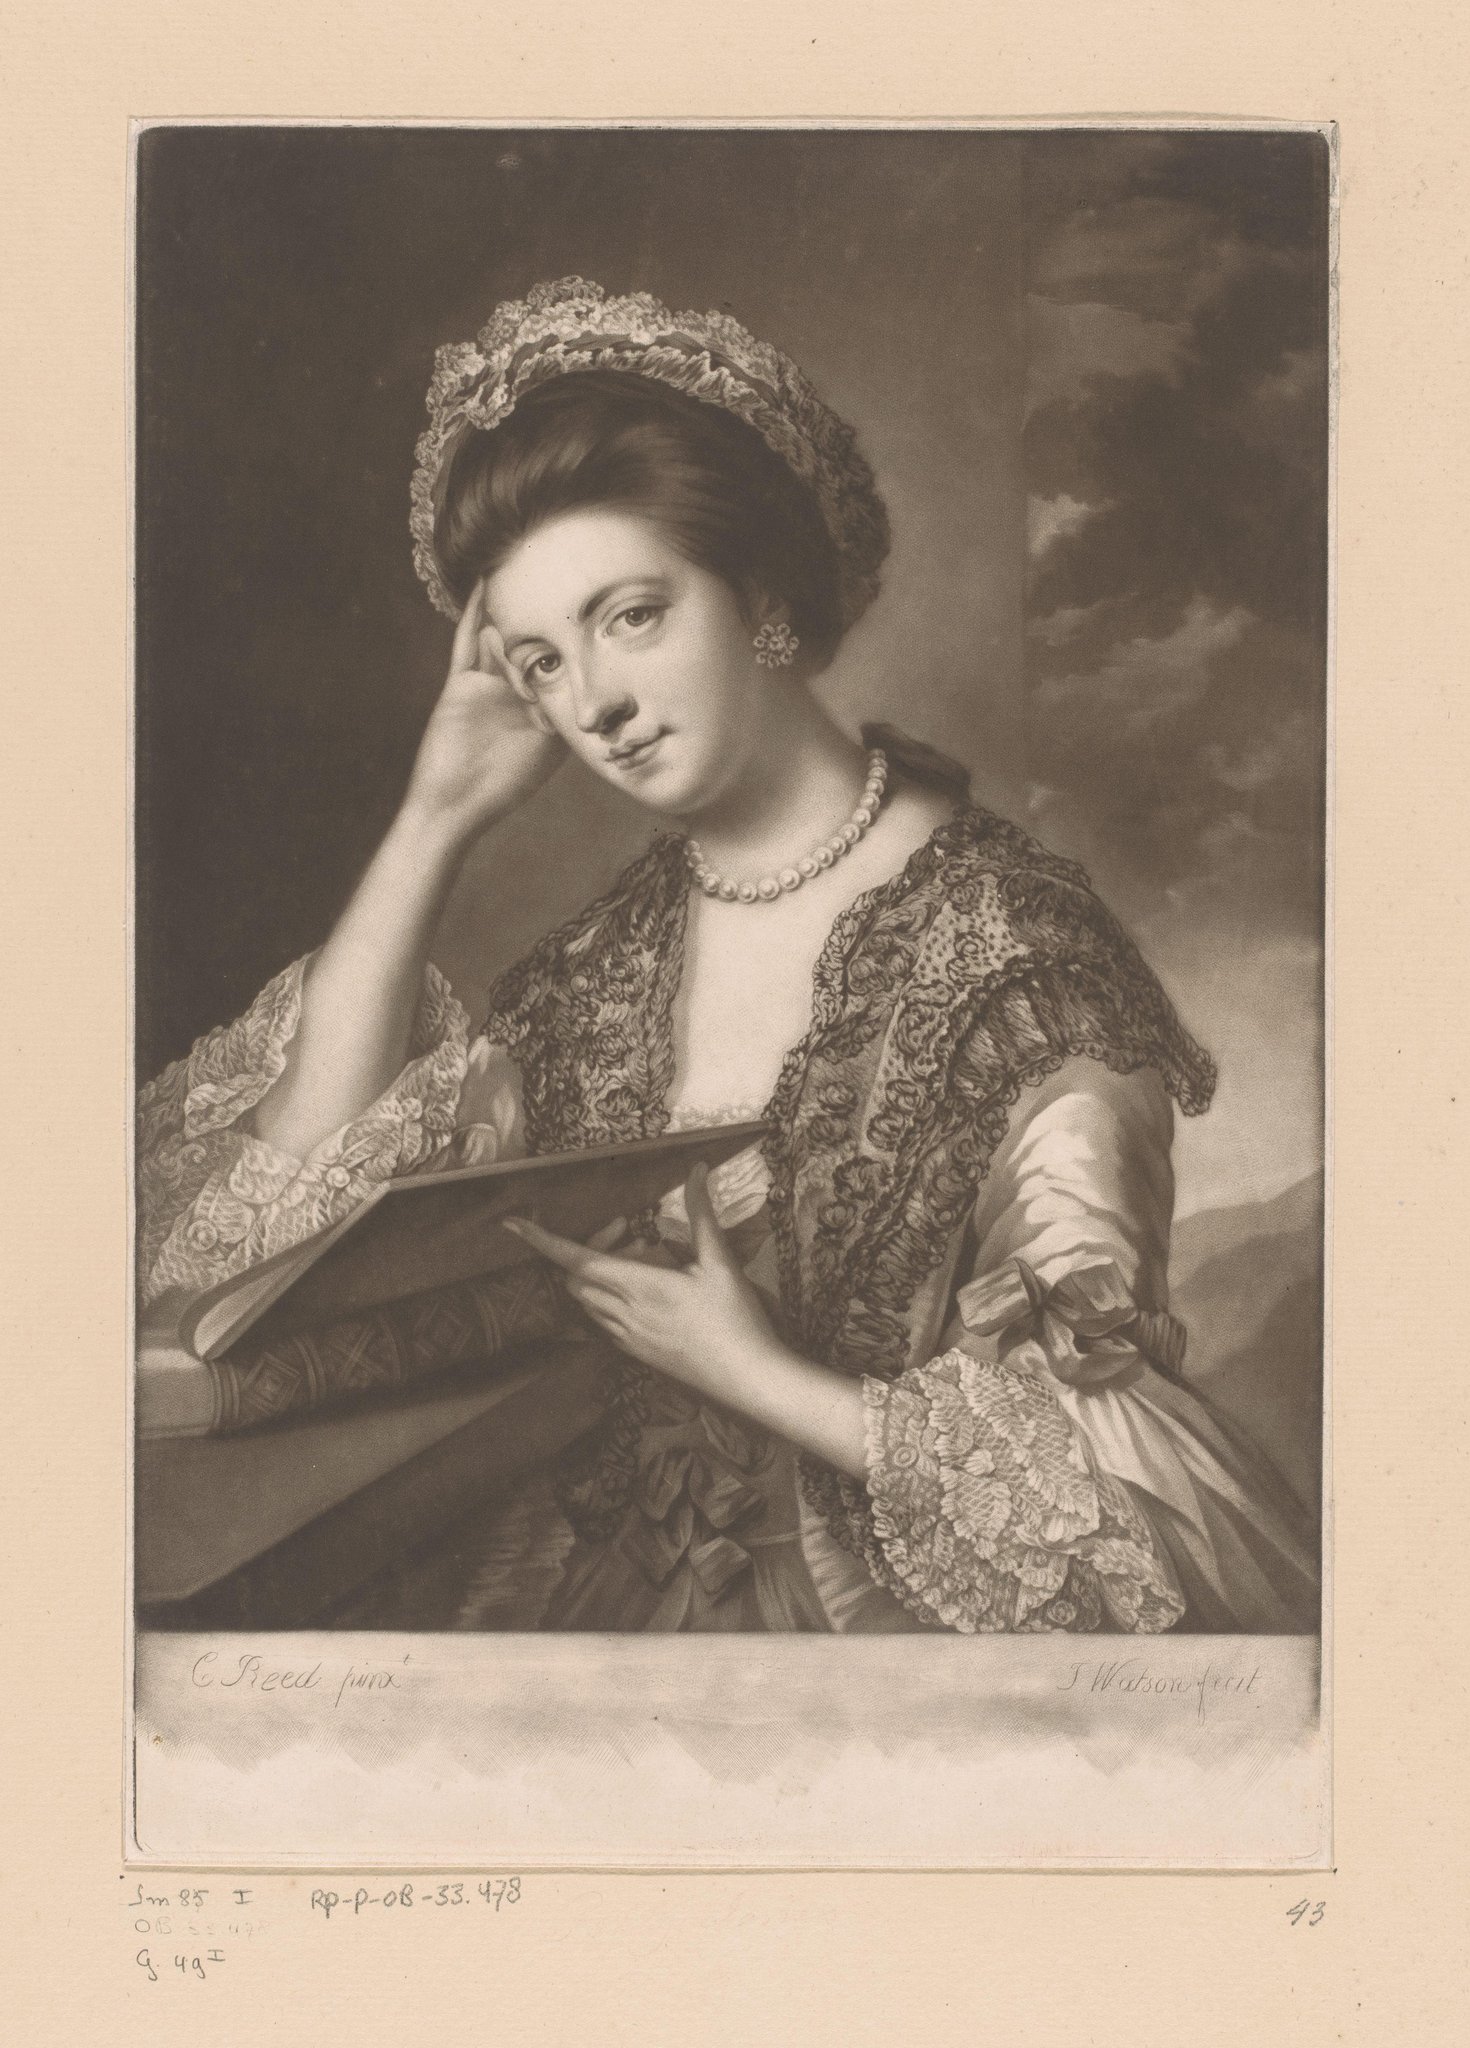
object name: print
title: Portret van een vrouw, mogelijk Polly Kennedy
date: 1767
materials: paper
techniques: mezzotint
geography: london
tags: historical persons - bb - woman, book - mm - book open, courtesan, hetaera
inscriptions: collector's mark: Lugt 240